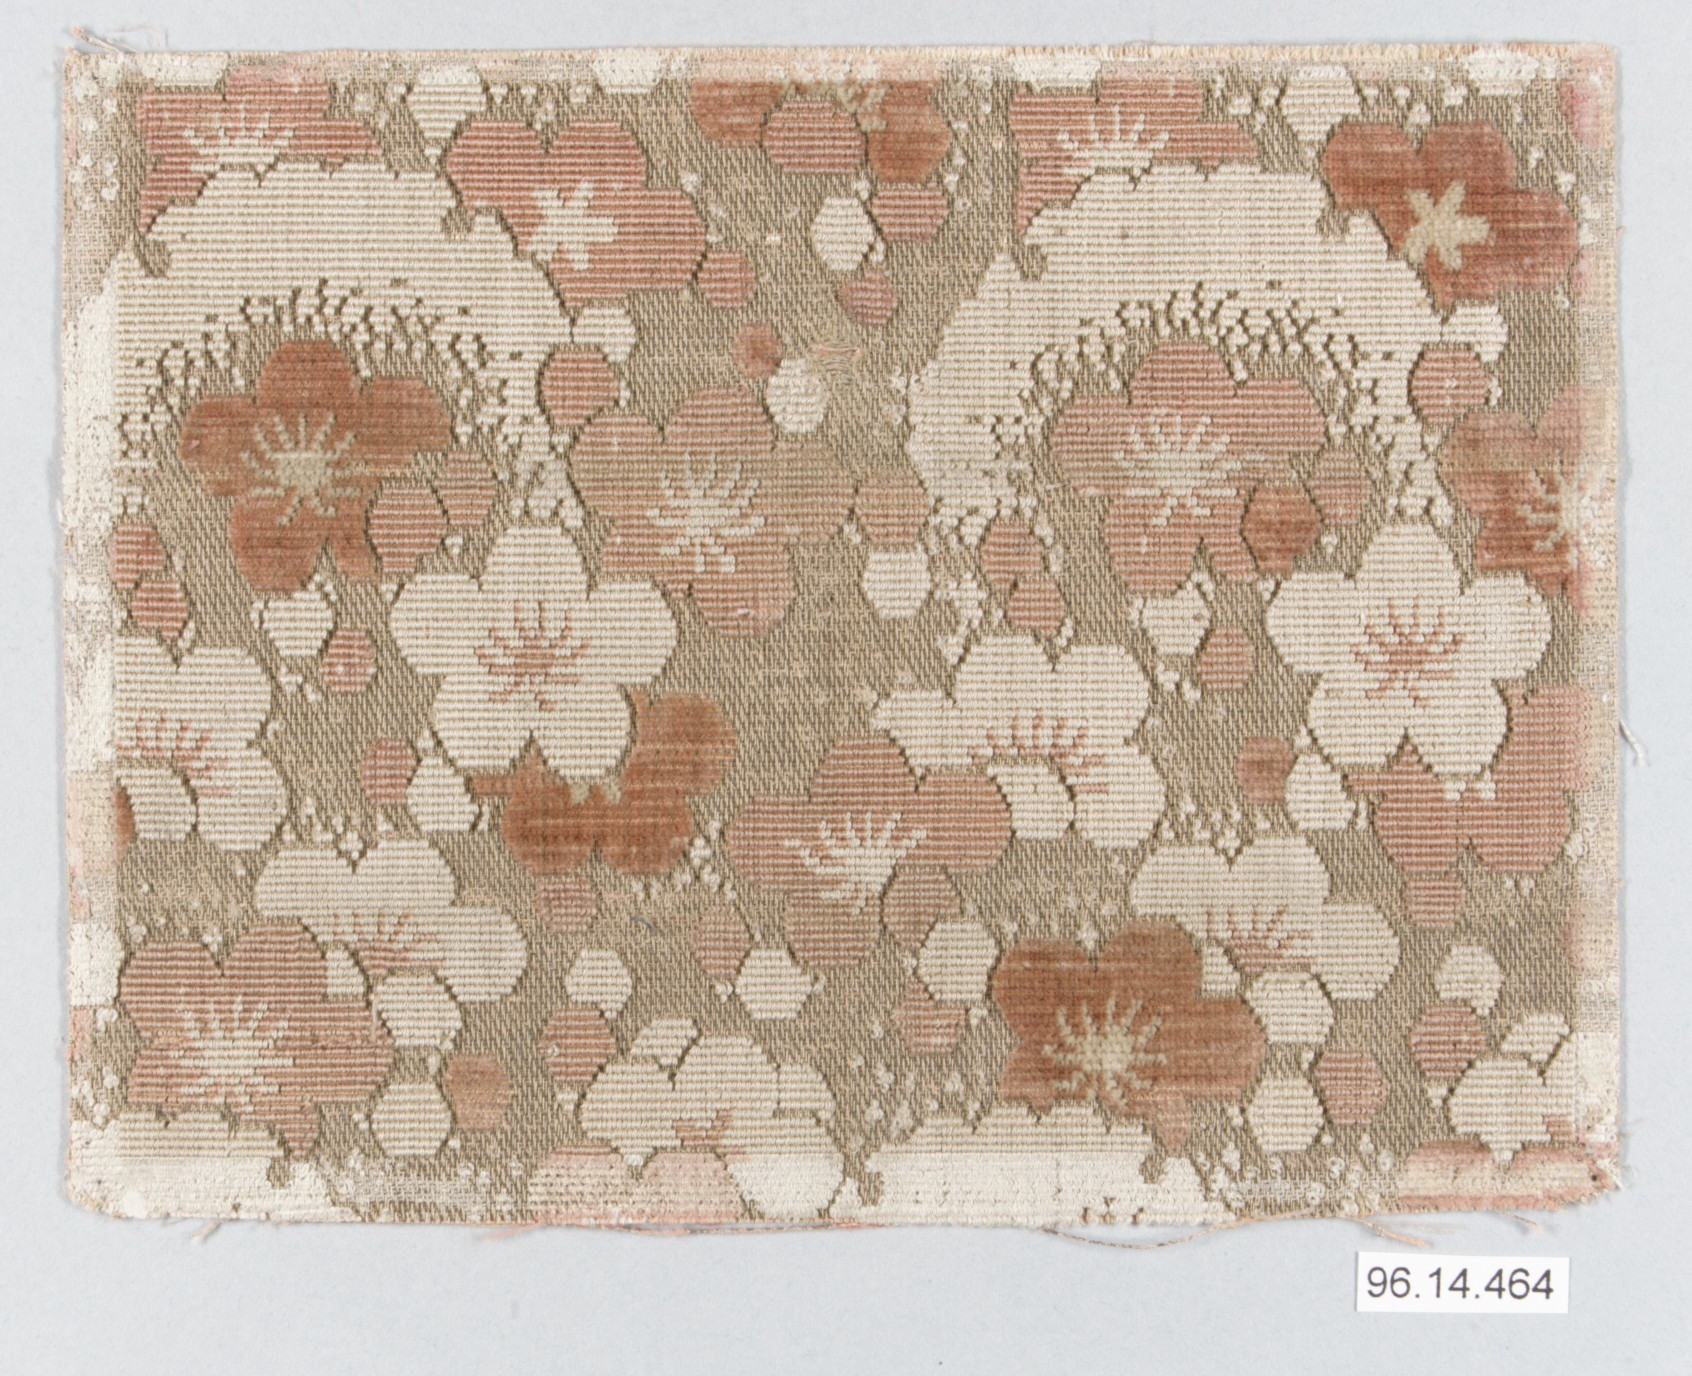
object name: piece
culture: japanese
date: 1801-1900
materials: silk